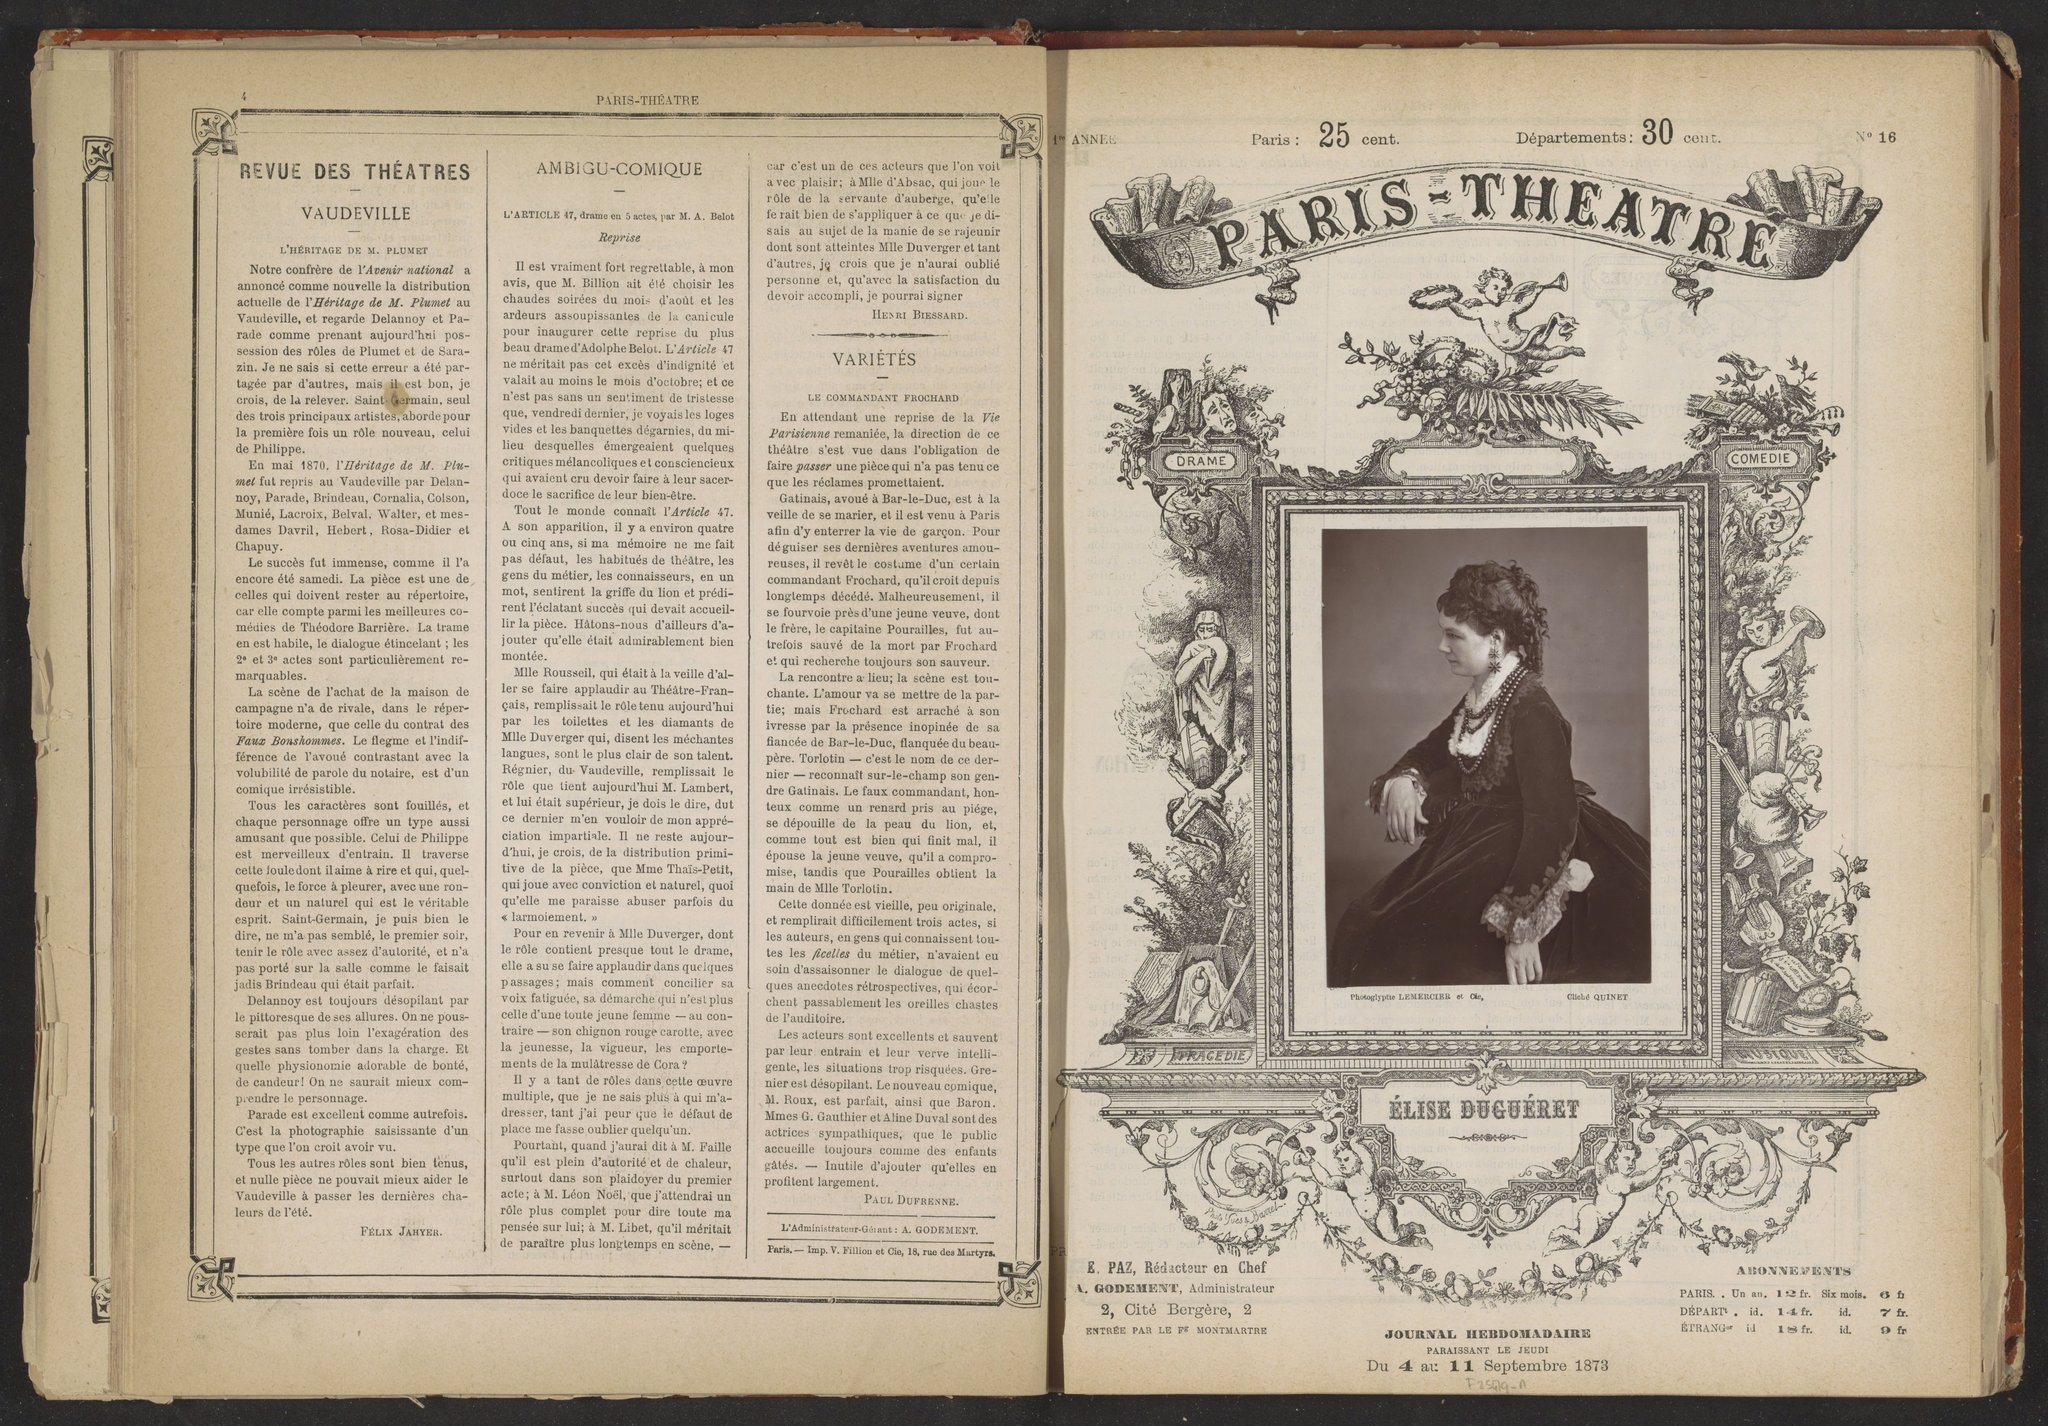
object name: photomechanical print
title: Portret van Élise Duguéret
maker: alexandre quinet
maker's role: fotograaf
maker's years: 1837-1900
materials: paper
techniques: woodburytype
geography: france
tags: portrait of actor, actress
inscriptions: number: ‘No 16’, inscription: ‘Journal hebdomadaire paraissant le jeudi Du 4 au 11 Septembre 1873’